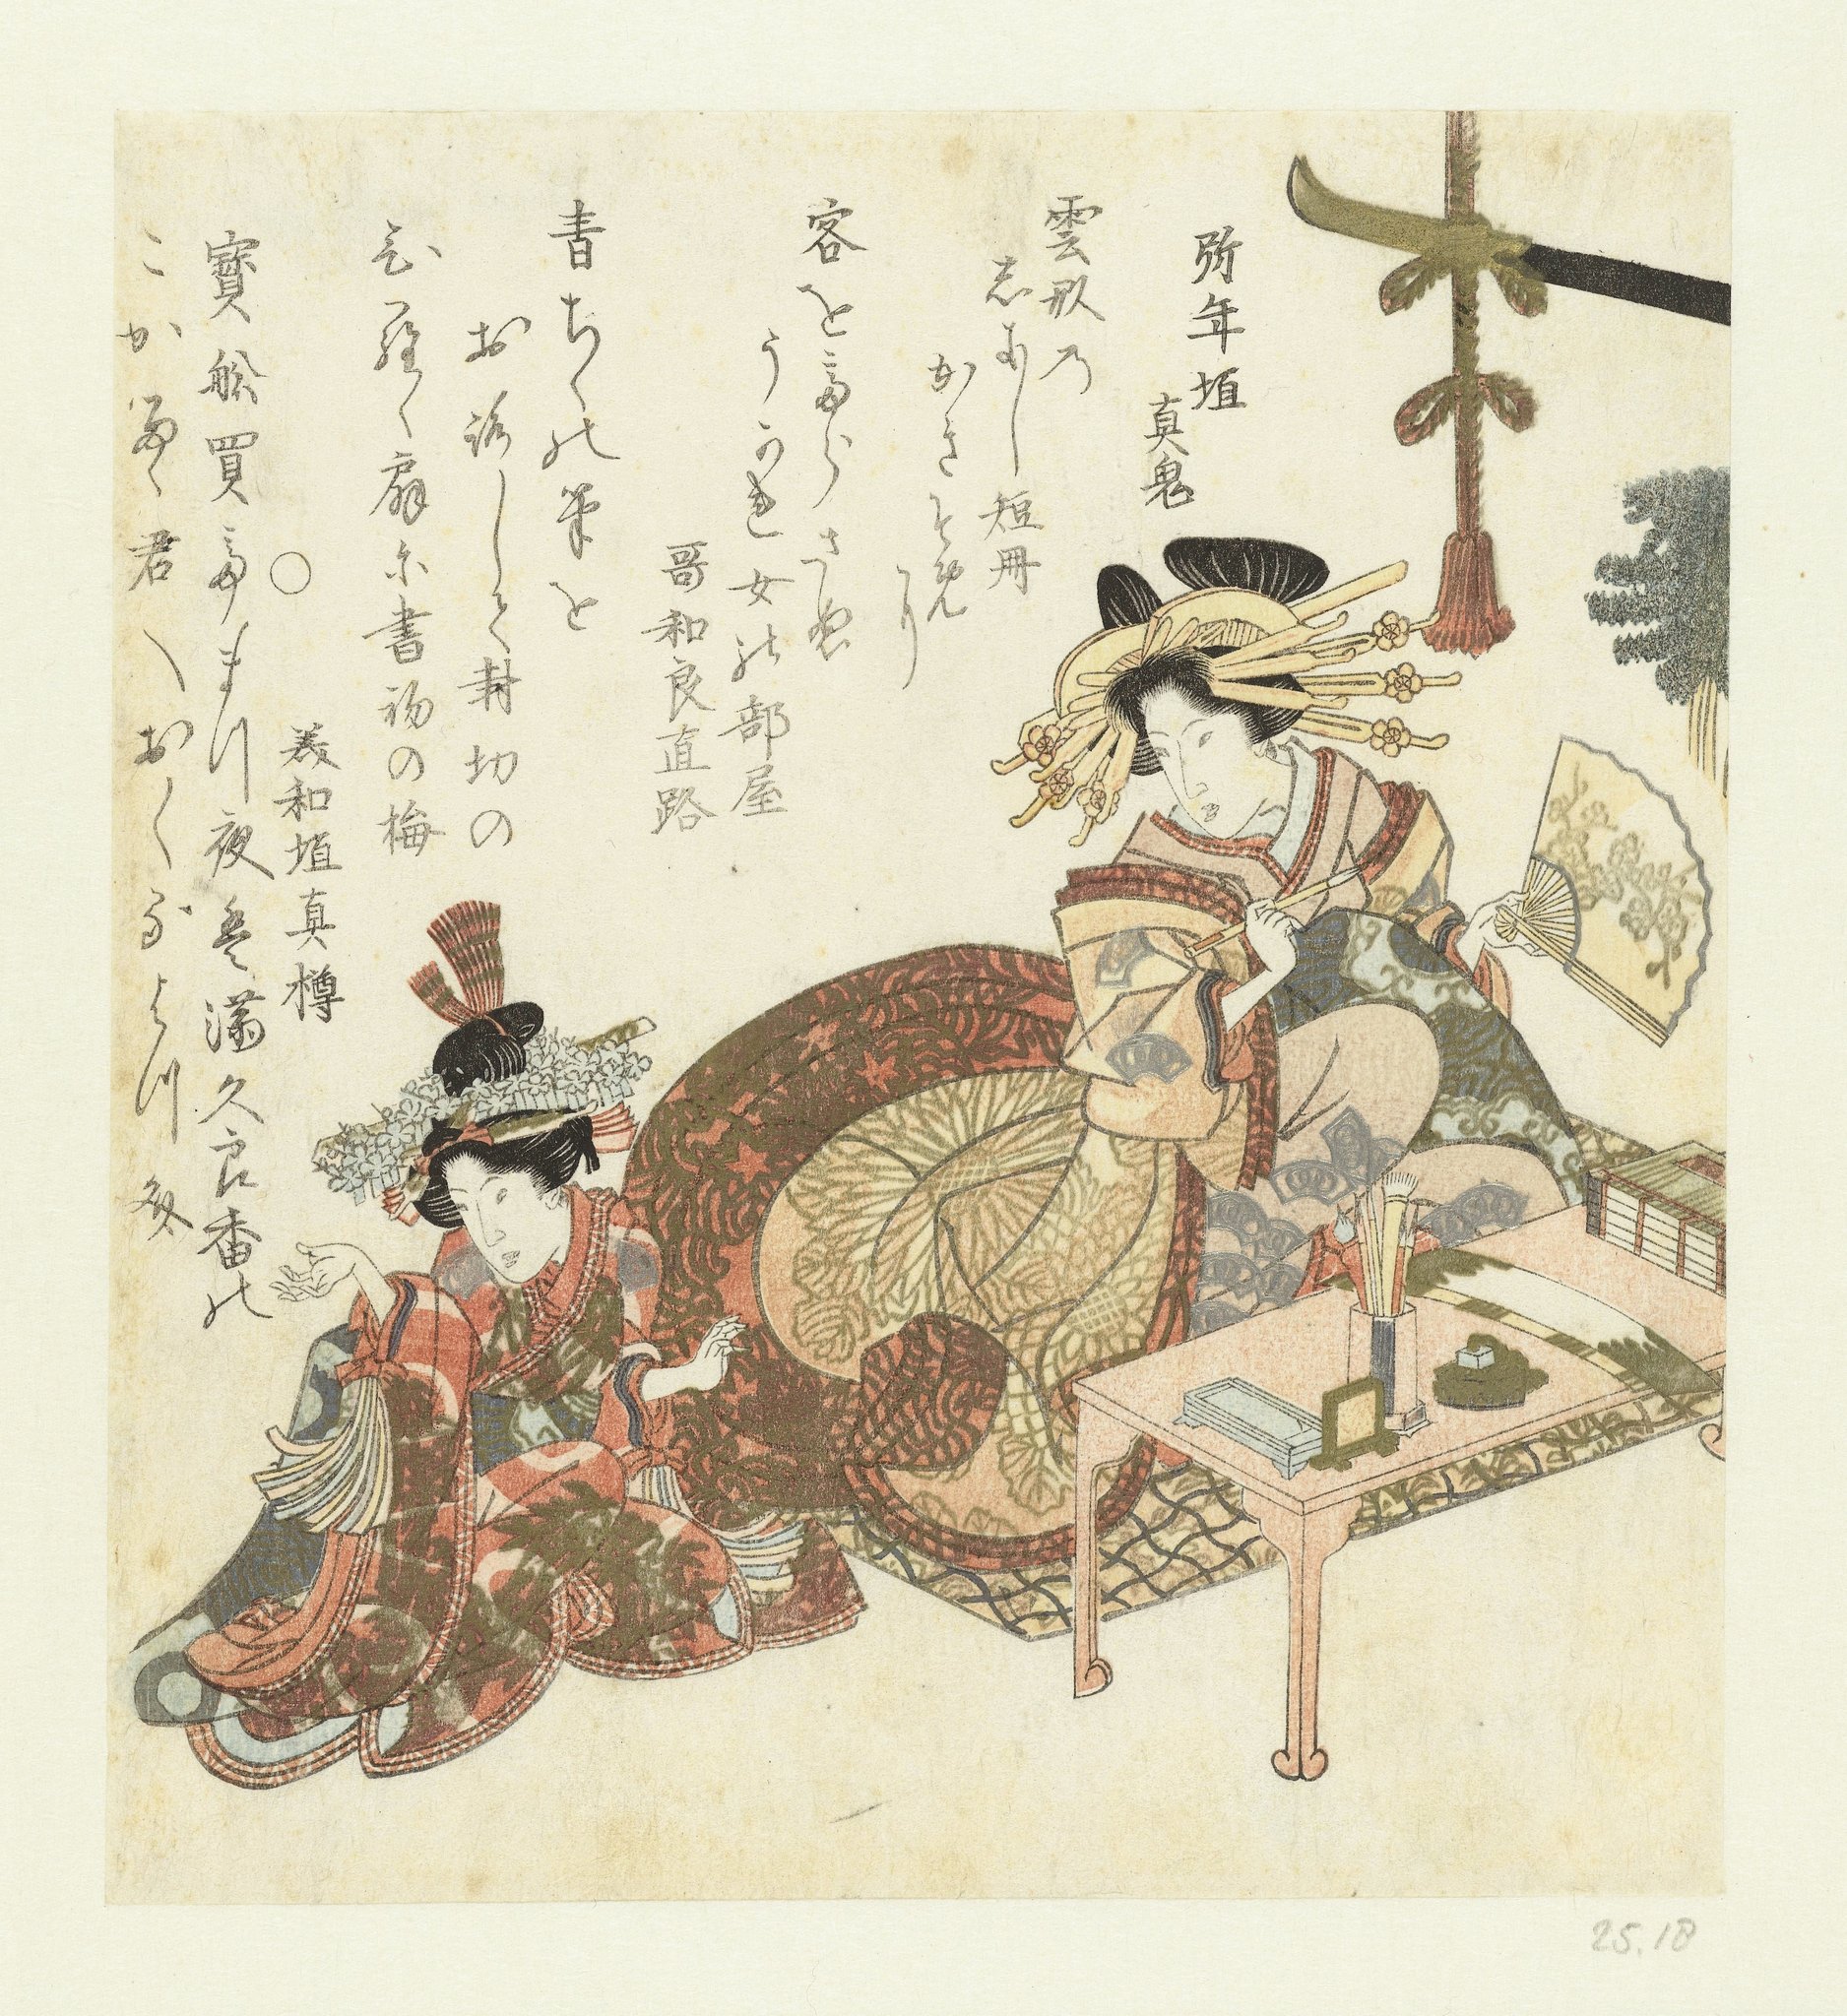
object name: surimono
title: Gedichten schrijvende oiran met dienares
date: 1820-1825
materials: paper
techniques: blind stamped, woodcut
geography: japan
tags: courtesan, hetaera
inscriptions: verso, stamped: Lugt 2228, collector's mark, passe-partout, bottom left, printed: JABdH with a rooster.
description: Een surimono is een luxe uitgevoerde prent waarop beeld met één of meerdere gedichten gecombineerd is. Bij het drukken van een surimono werd vaak gebruik gemaakt van dikker papier, blinddruk en metaal pigmenten, zoals koper- en zilverpoeder. De prenten werden vaak in opdracht van dichters gemaakt en als exclusief geschenk aan vrienden en relaties gegeven.